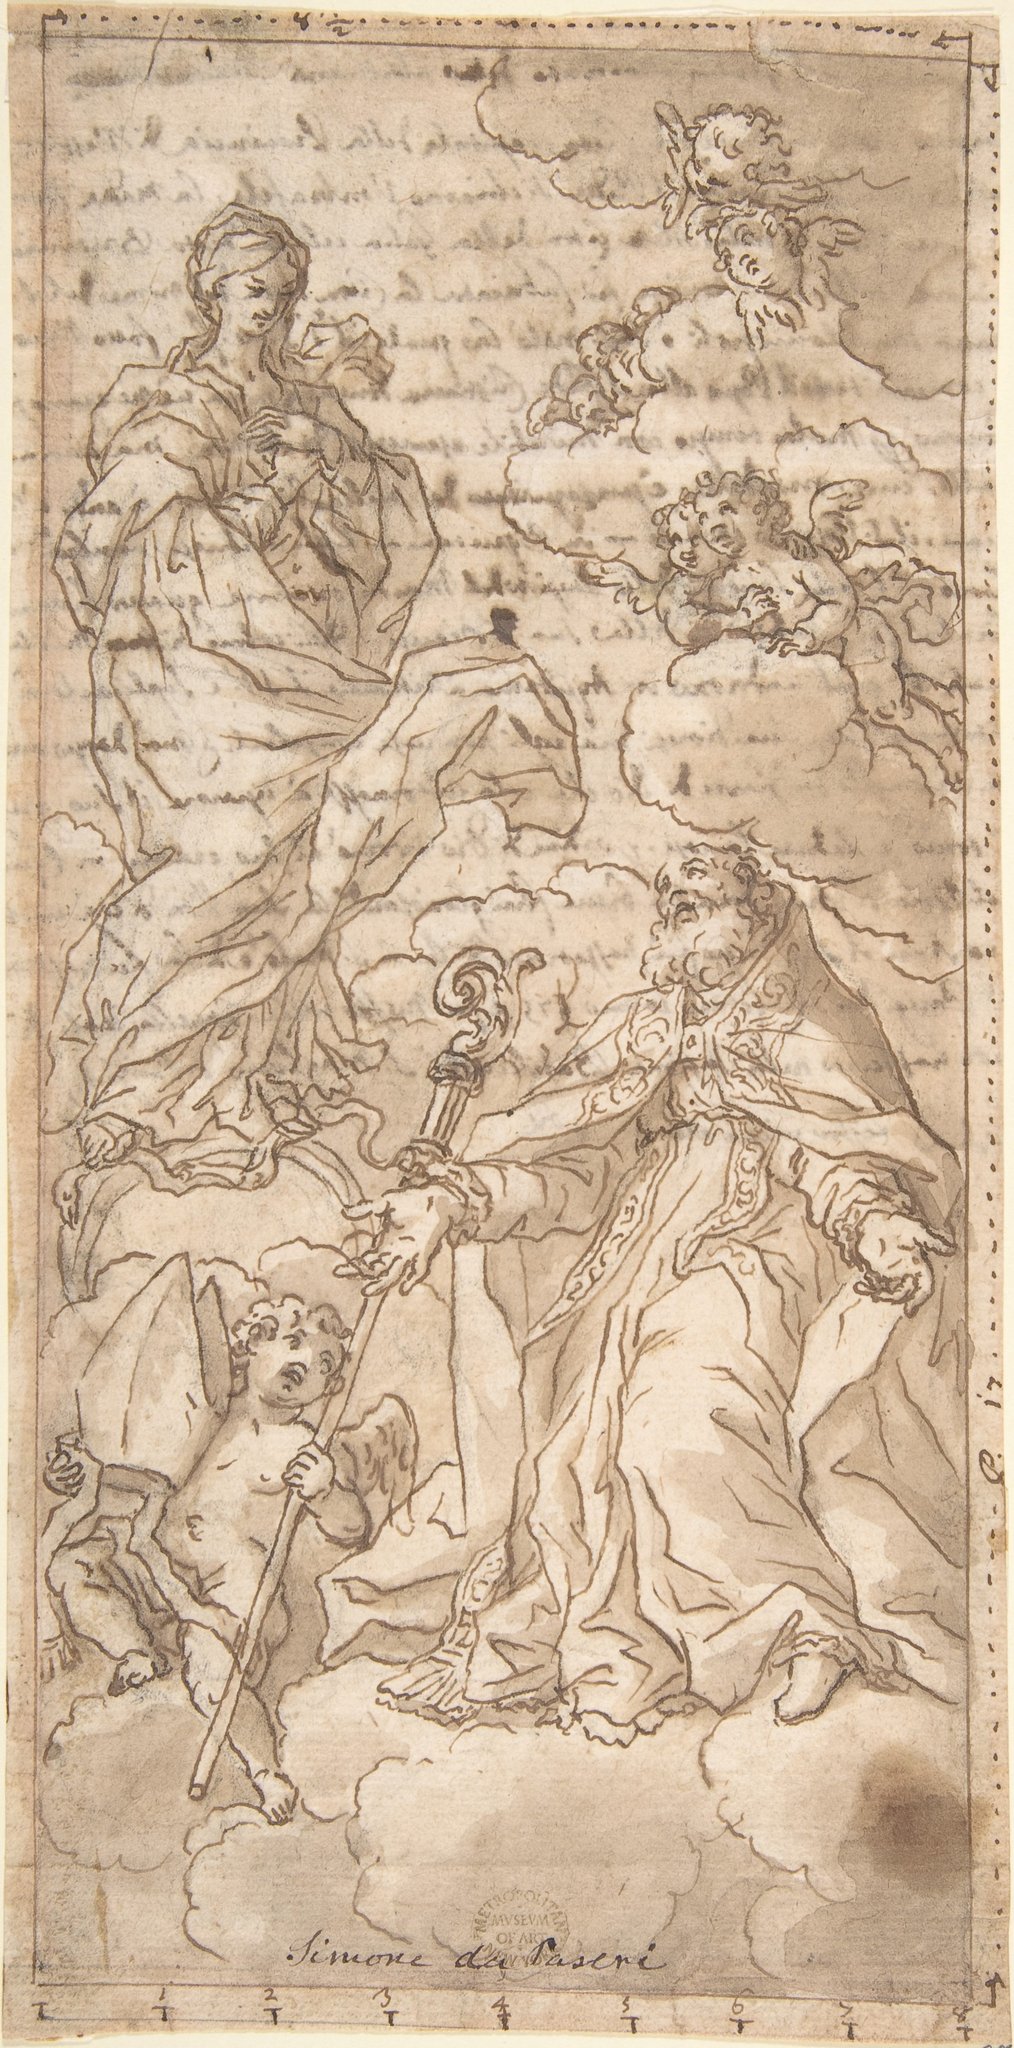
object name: drawing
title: A Bishop in Ecstasy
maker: anonymous, italian, roman-bolognese, 17th century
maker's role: artist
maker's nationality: italian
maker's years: 1600-1700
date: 1601-1700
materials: chalk, ink, paper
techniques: brush, pen, wash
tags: men,women,putti,bishops